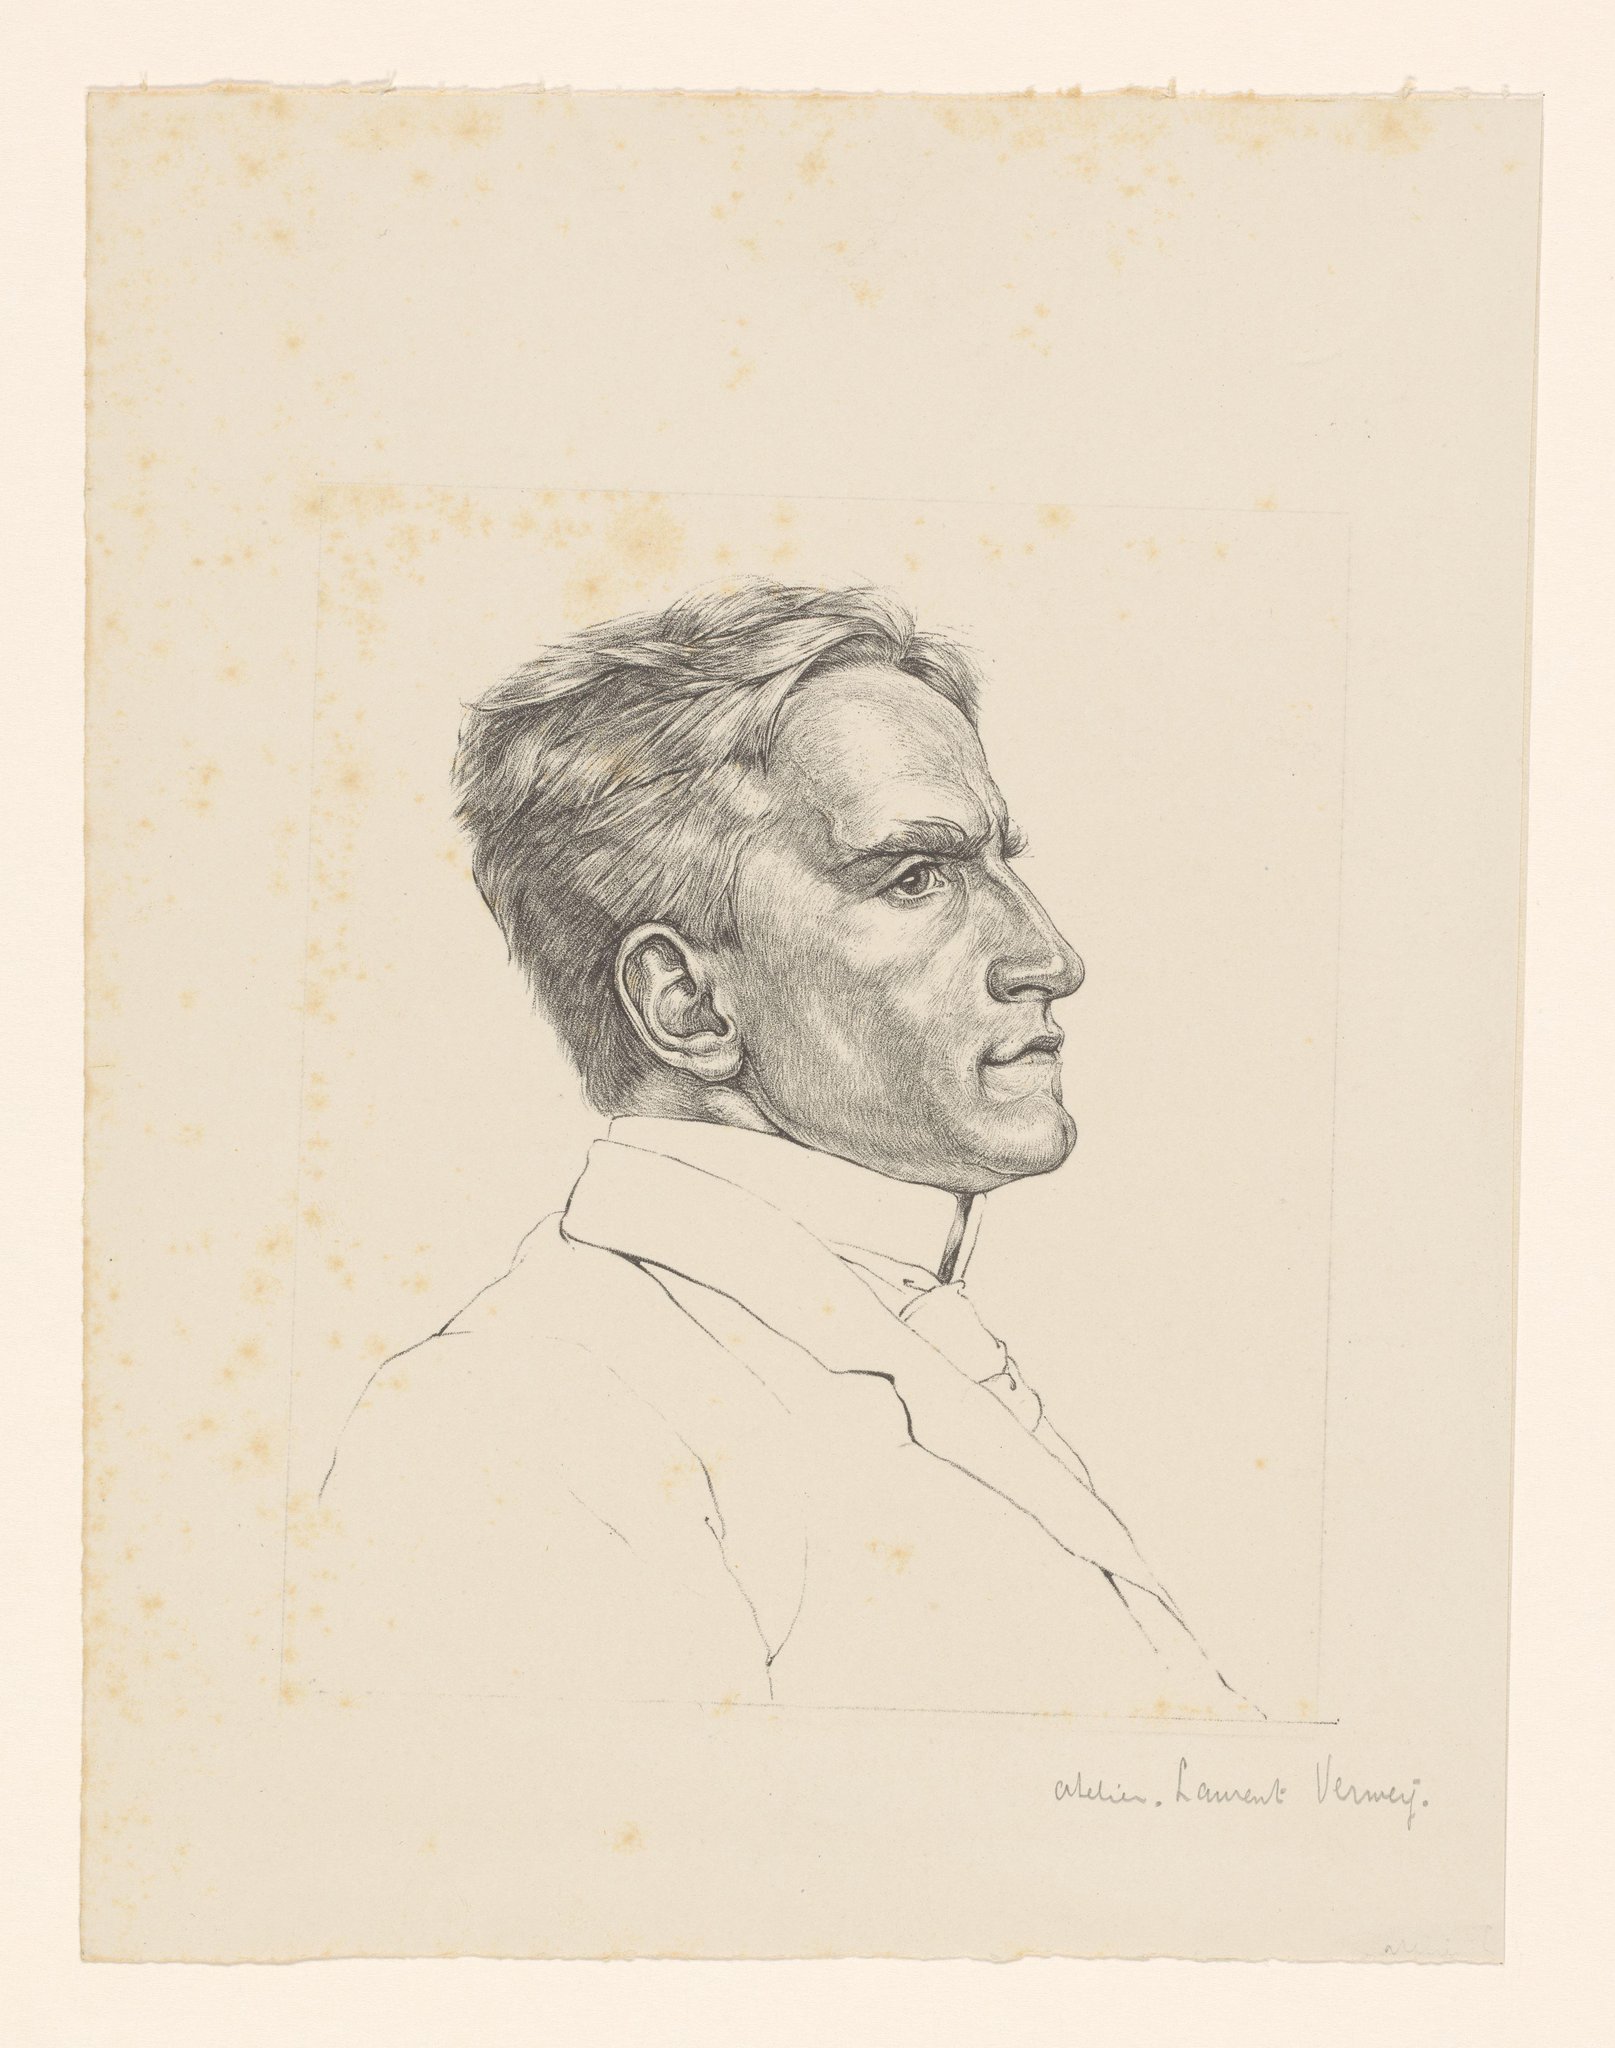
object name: print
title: Portret van een onbekende man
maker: laurent verwey van udenhout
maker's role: print maker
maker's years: 1884-1913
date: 1894-1913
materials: paper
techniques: lithograph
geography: netherlands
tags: historical persons not known by name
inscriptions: collector's mark: Lugt 2228